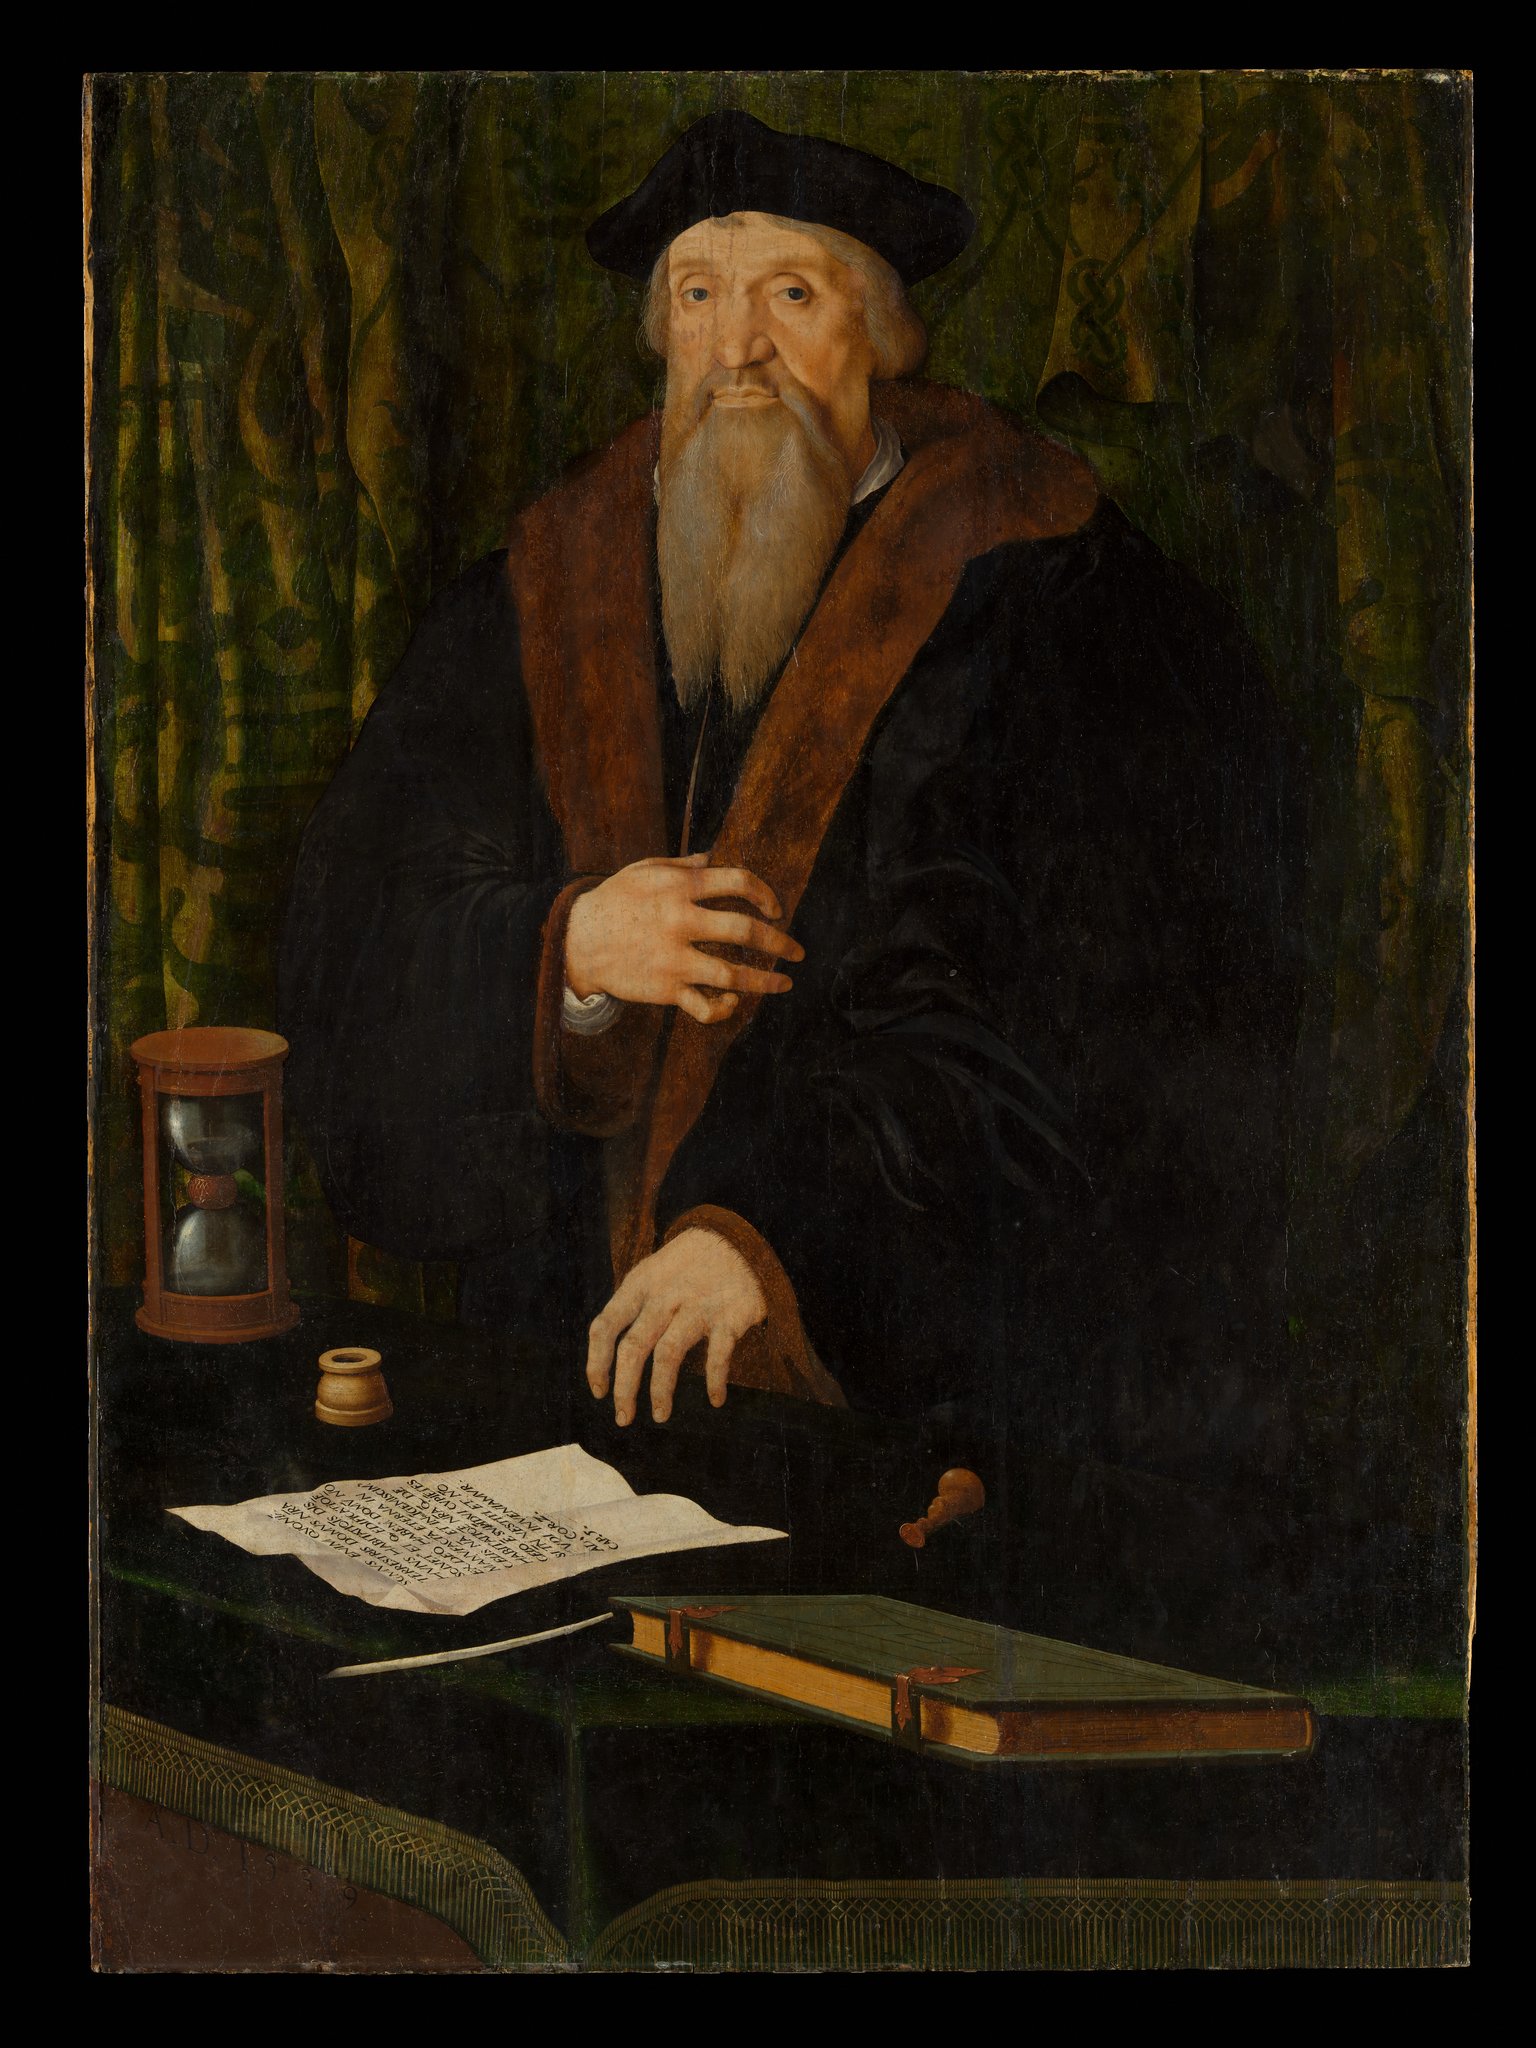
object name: painting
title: Portrait of a Man, Possibly Jean de Langeac (died 1541), Bishop of Limoges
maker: netherlandish painter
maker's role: artist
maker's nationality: netherlandish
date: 1539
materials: oil, wood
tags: men,portraits,hourglass